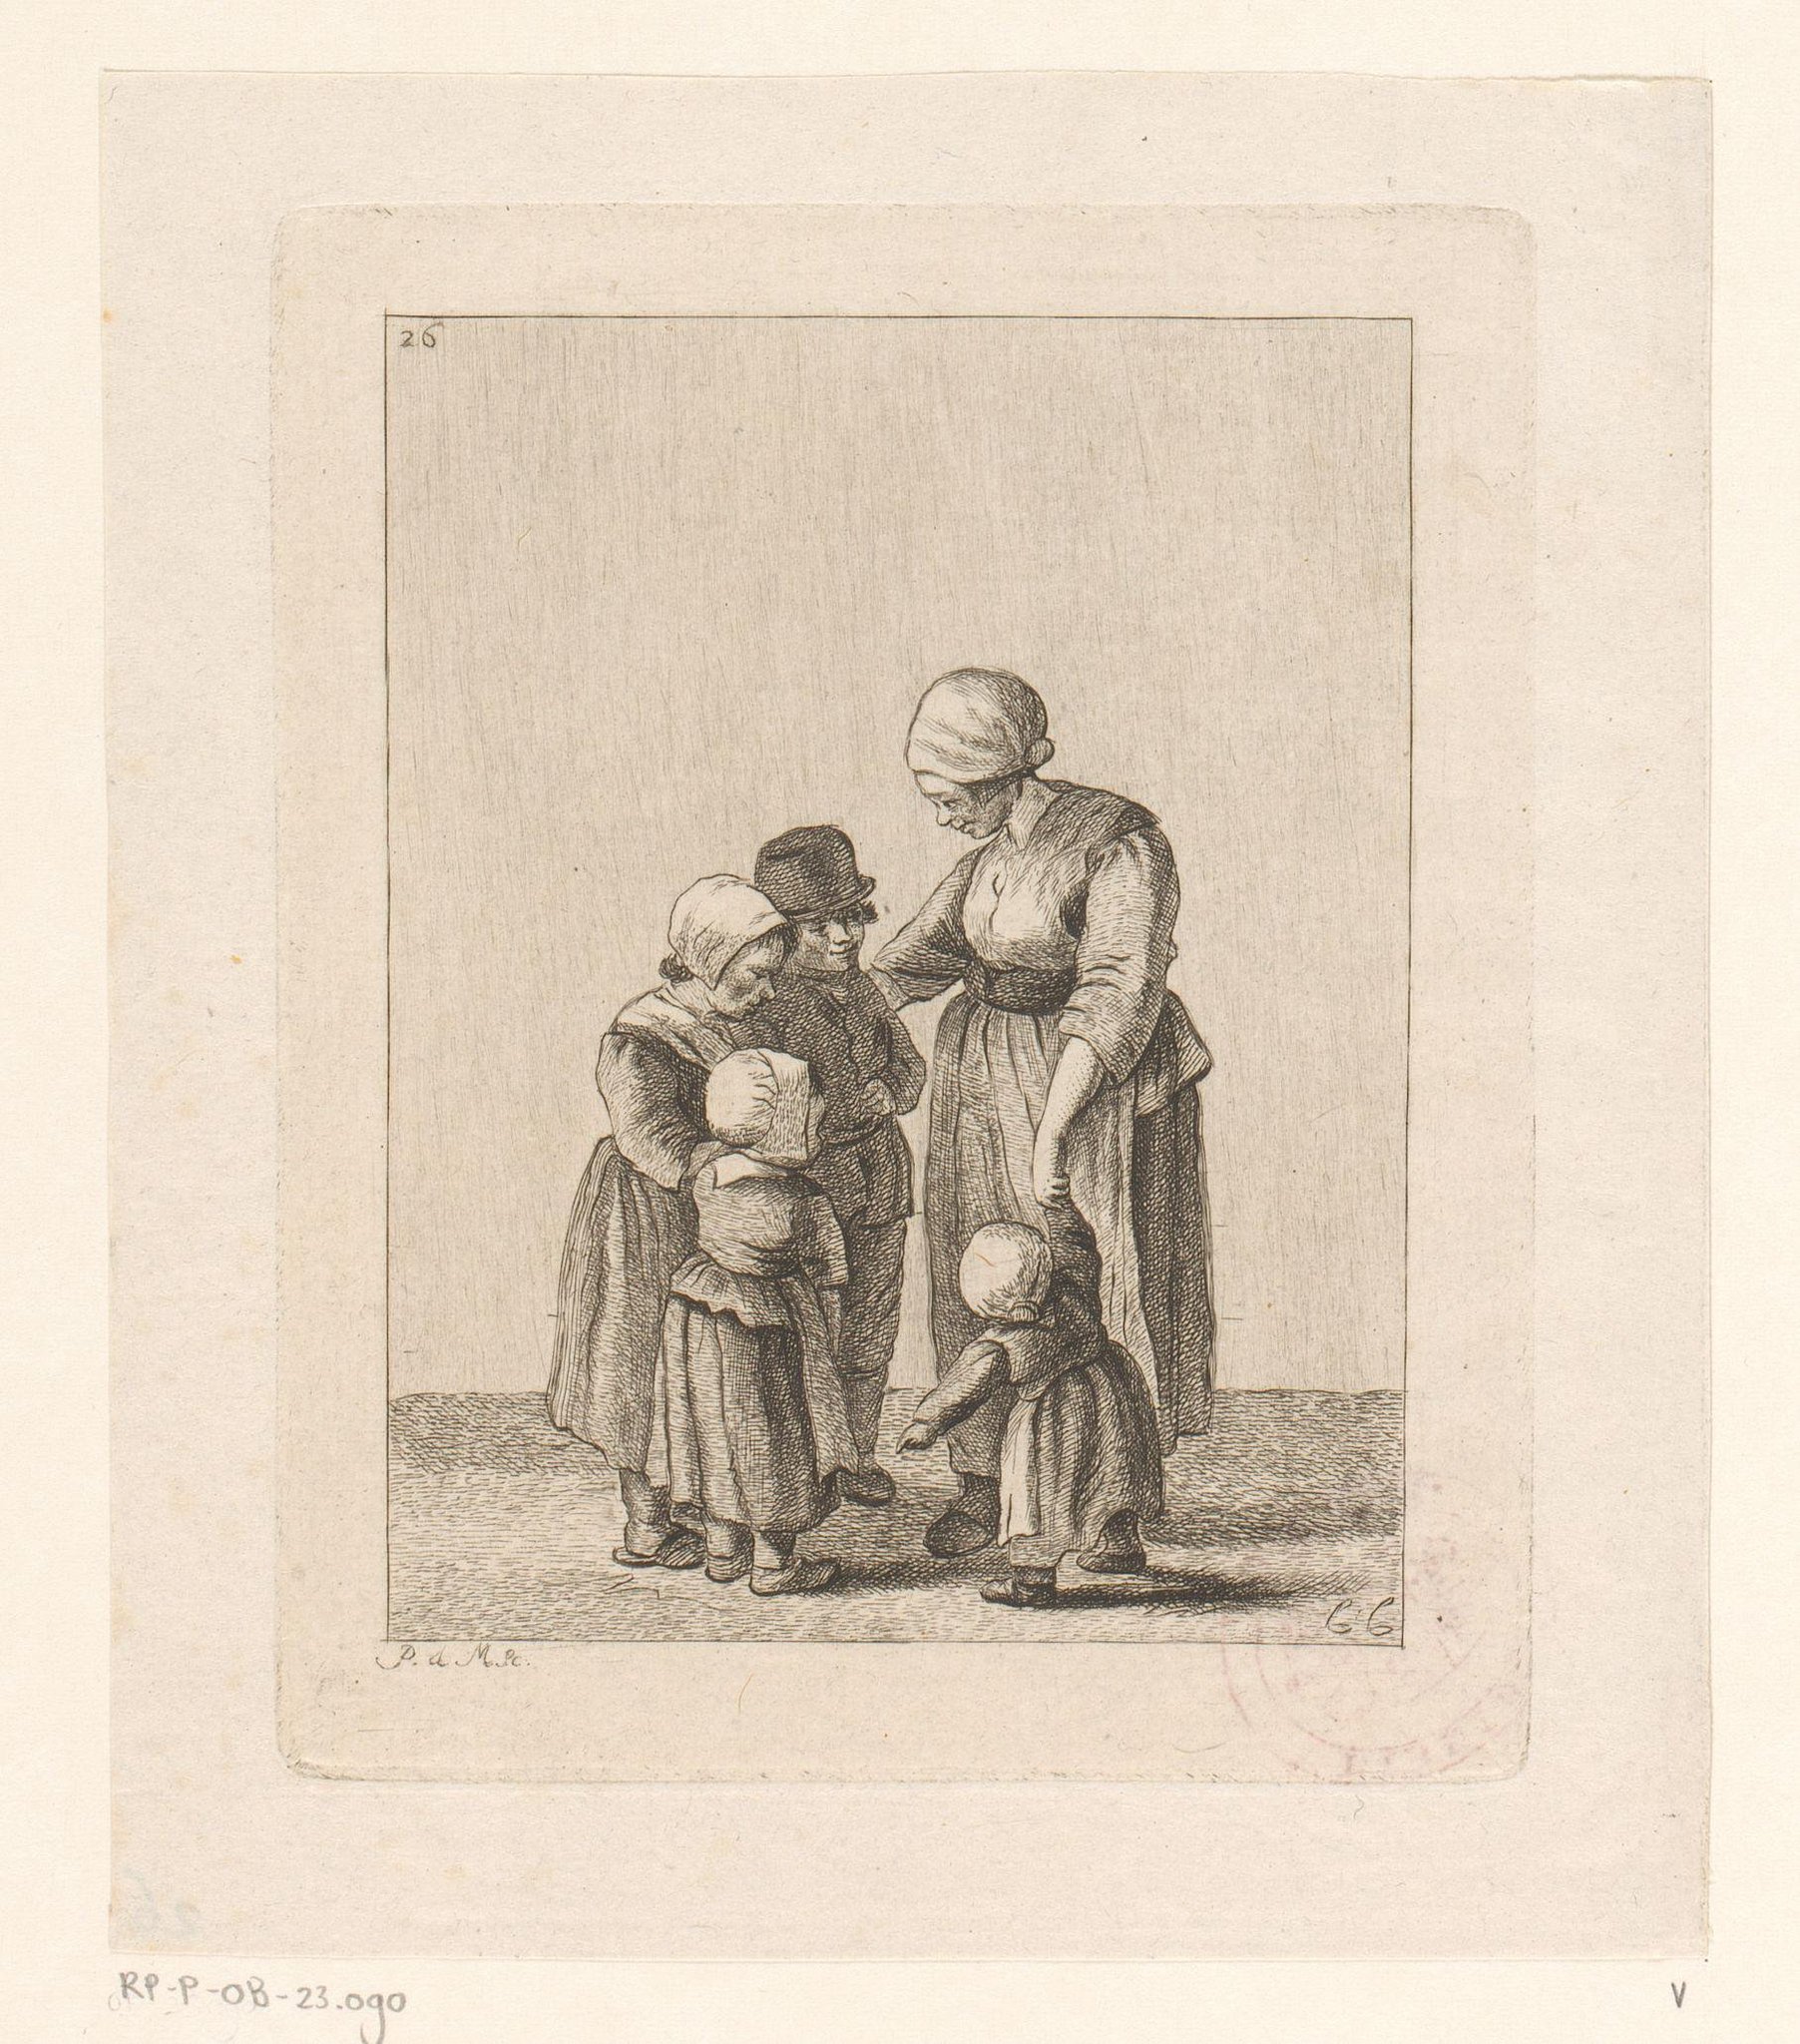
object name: print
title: Moeder met vier kinderen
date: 1779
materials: paper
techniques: etching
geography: leiden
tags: mother and baby or young child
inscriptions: collector's mark: Lugt 240